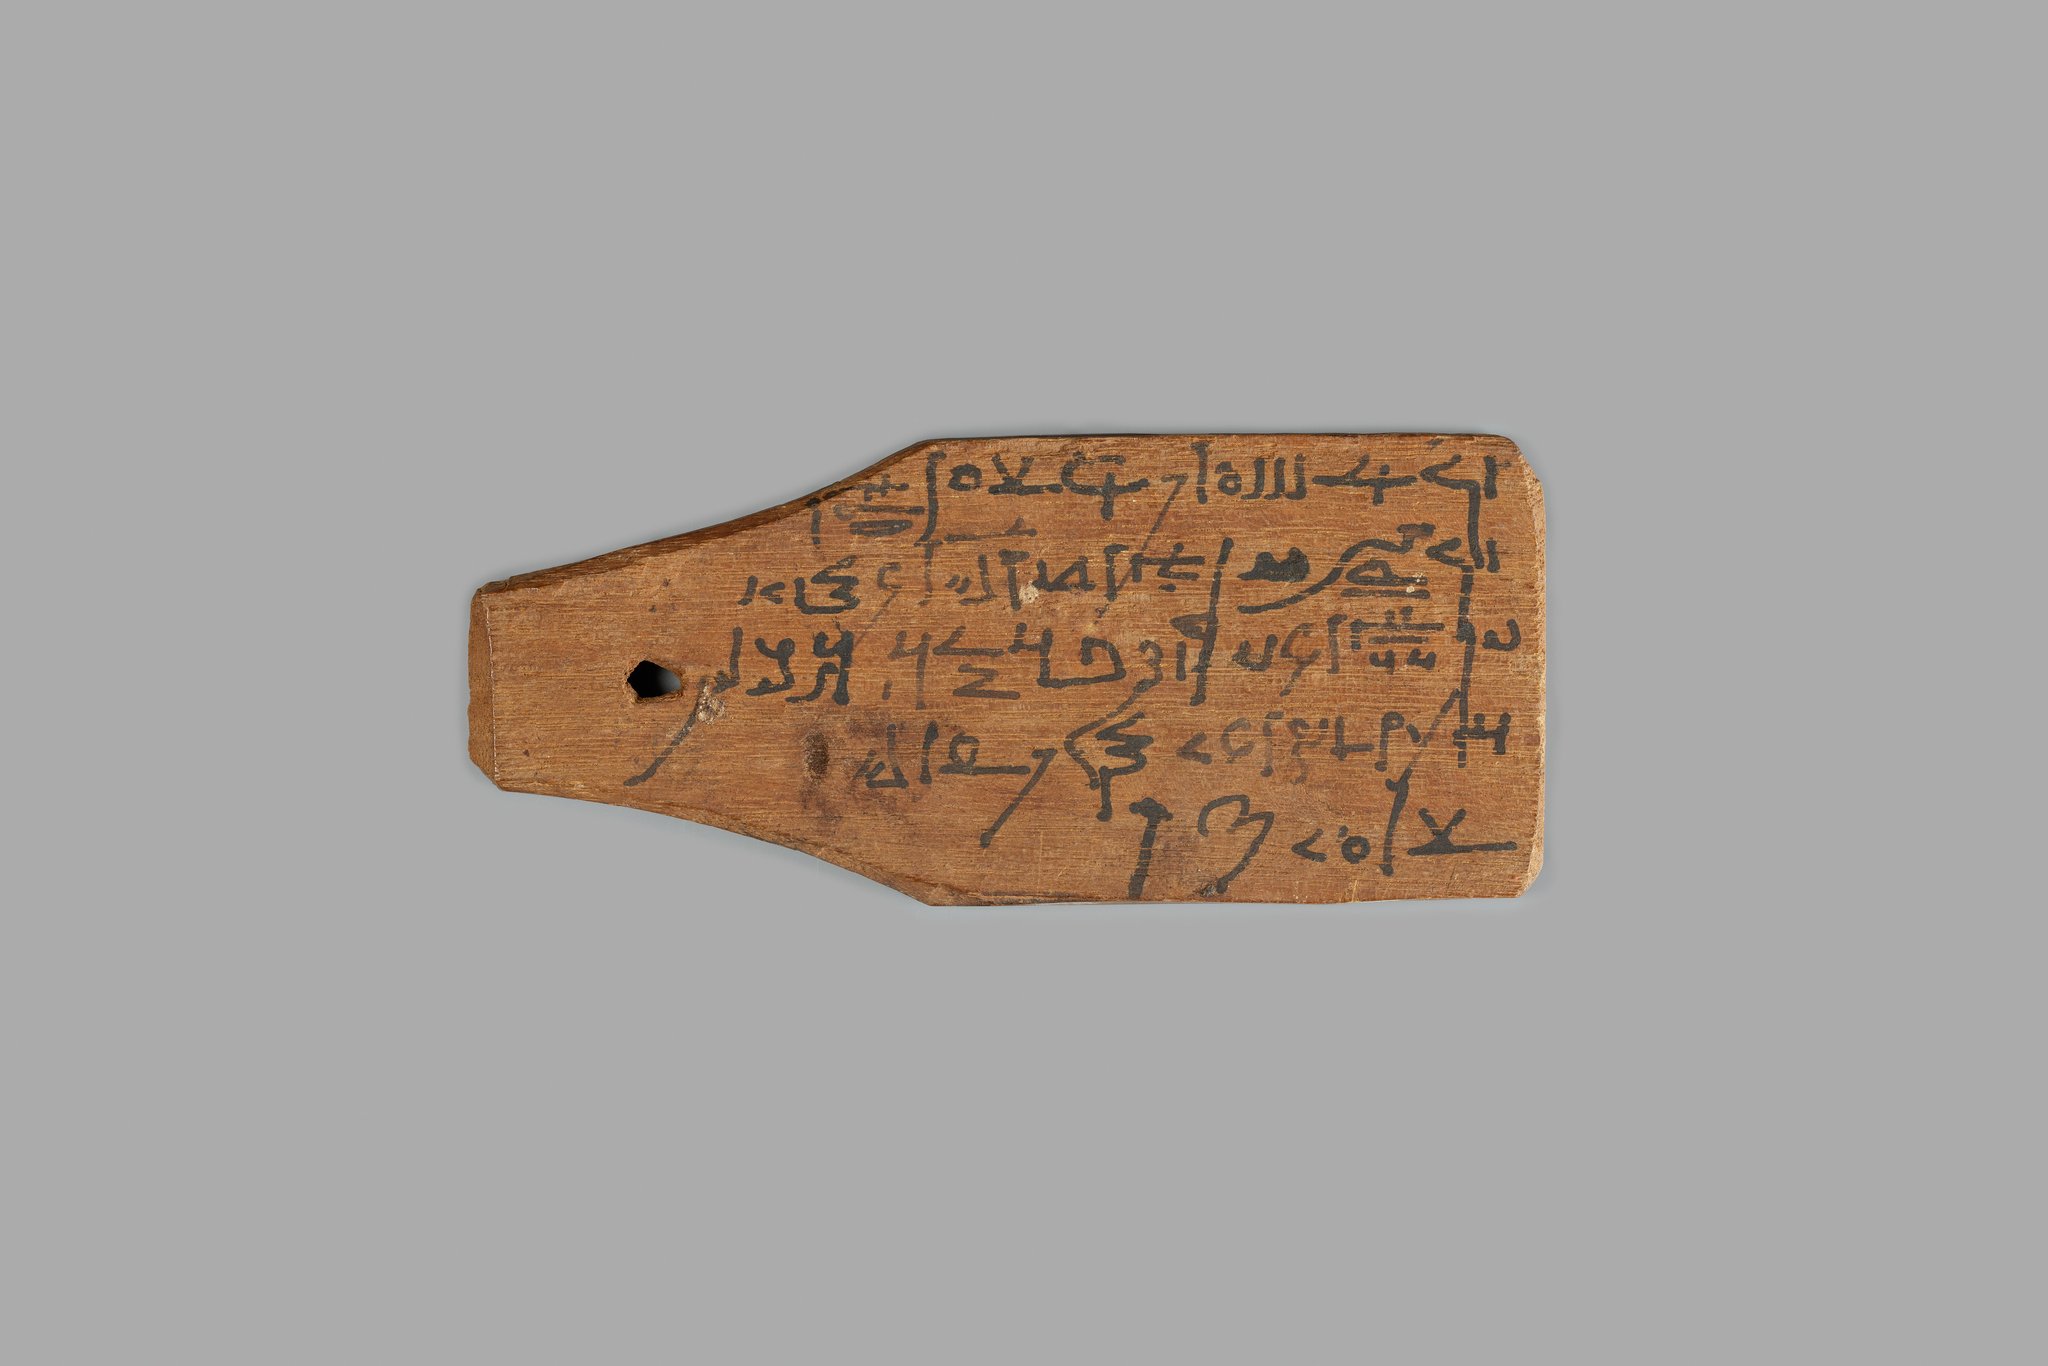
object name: mummy label, petempto the younger, son of petemin, his mother kolluthe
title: Mummy label of Petempto the younger, age 79, son of Petemin; his mother Kolluthe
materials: ink, wood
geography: northern upper egypt